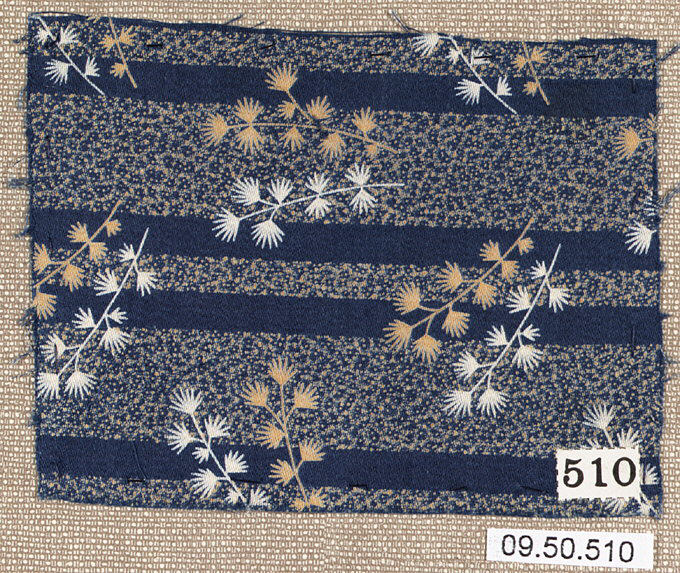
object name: piece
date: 1801-1900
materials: cotton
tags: leaves